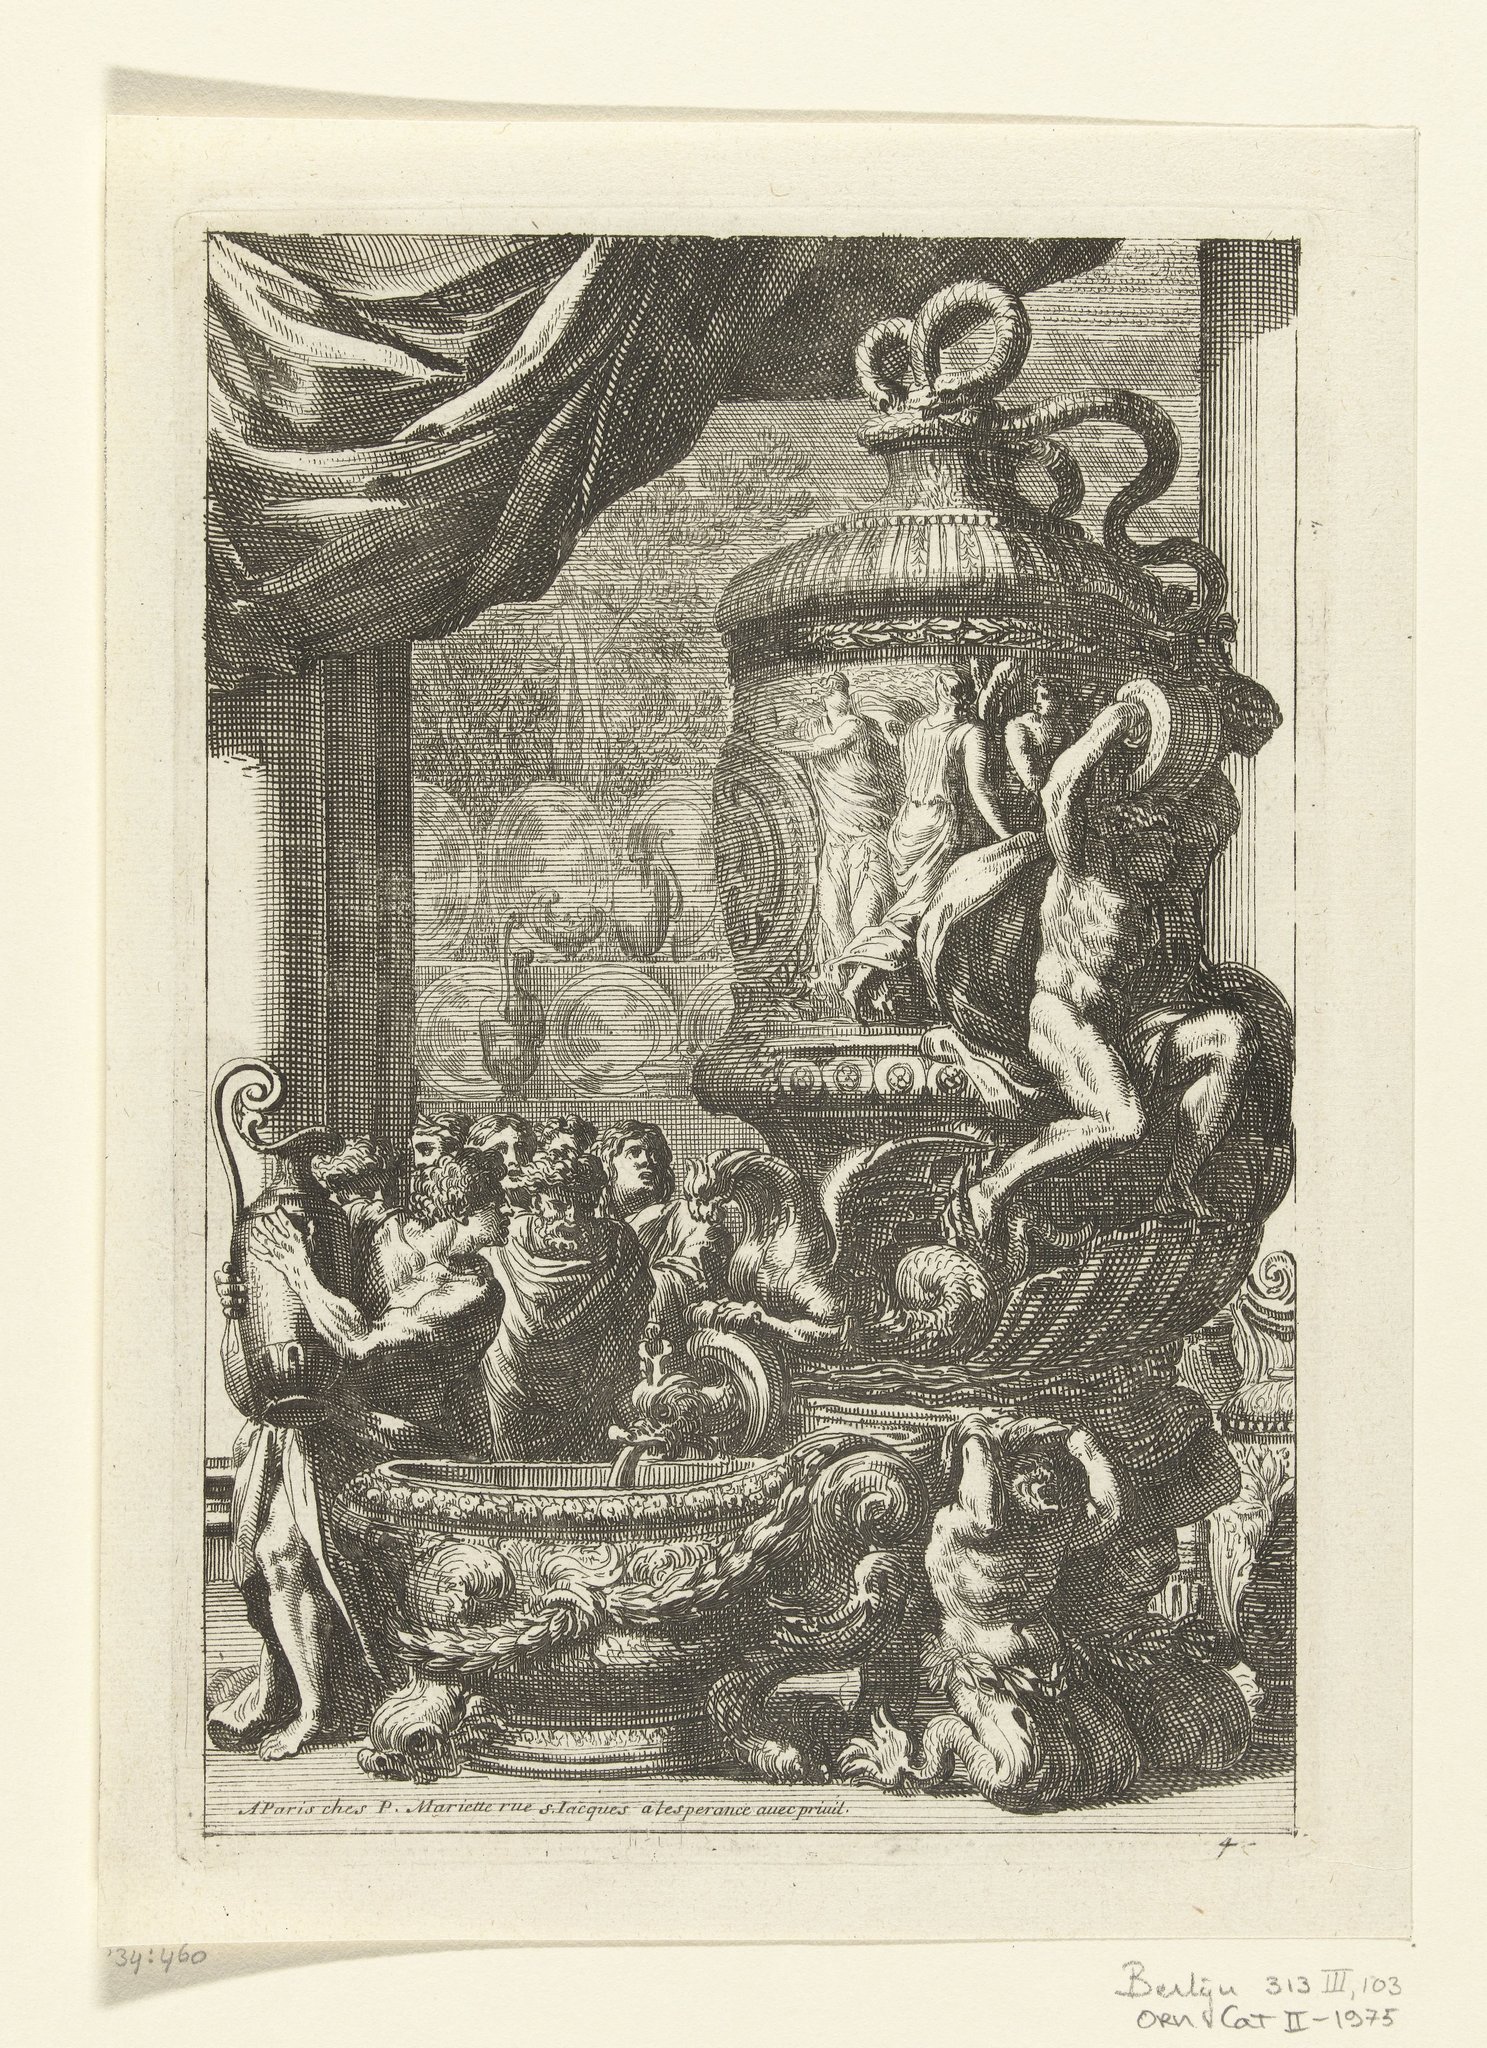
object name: ornament print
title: Fonteines et Cuuettes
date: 1657-1661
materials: paper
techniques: etching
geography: paris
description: Een naakte man ondersteunt het handvat. Links van de fontein staan figuren naast een bassin.